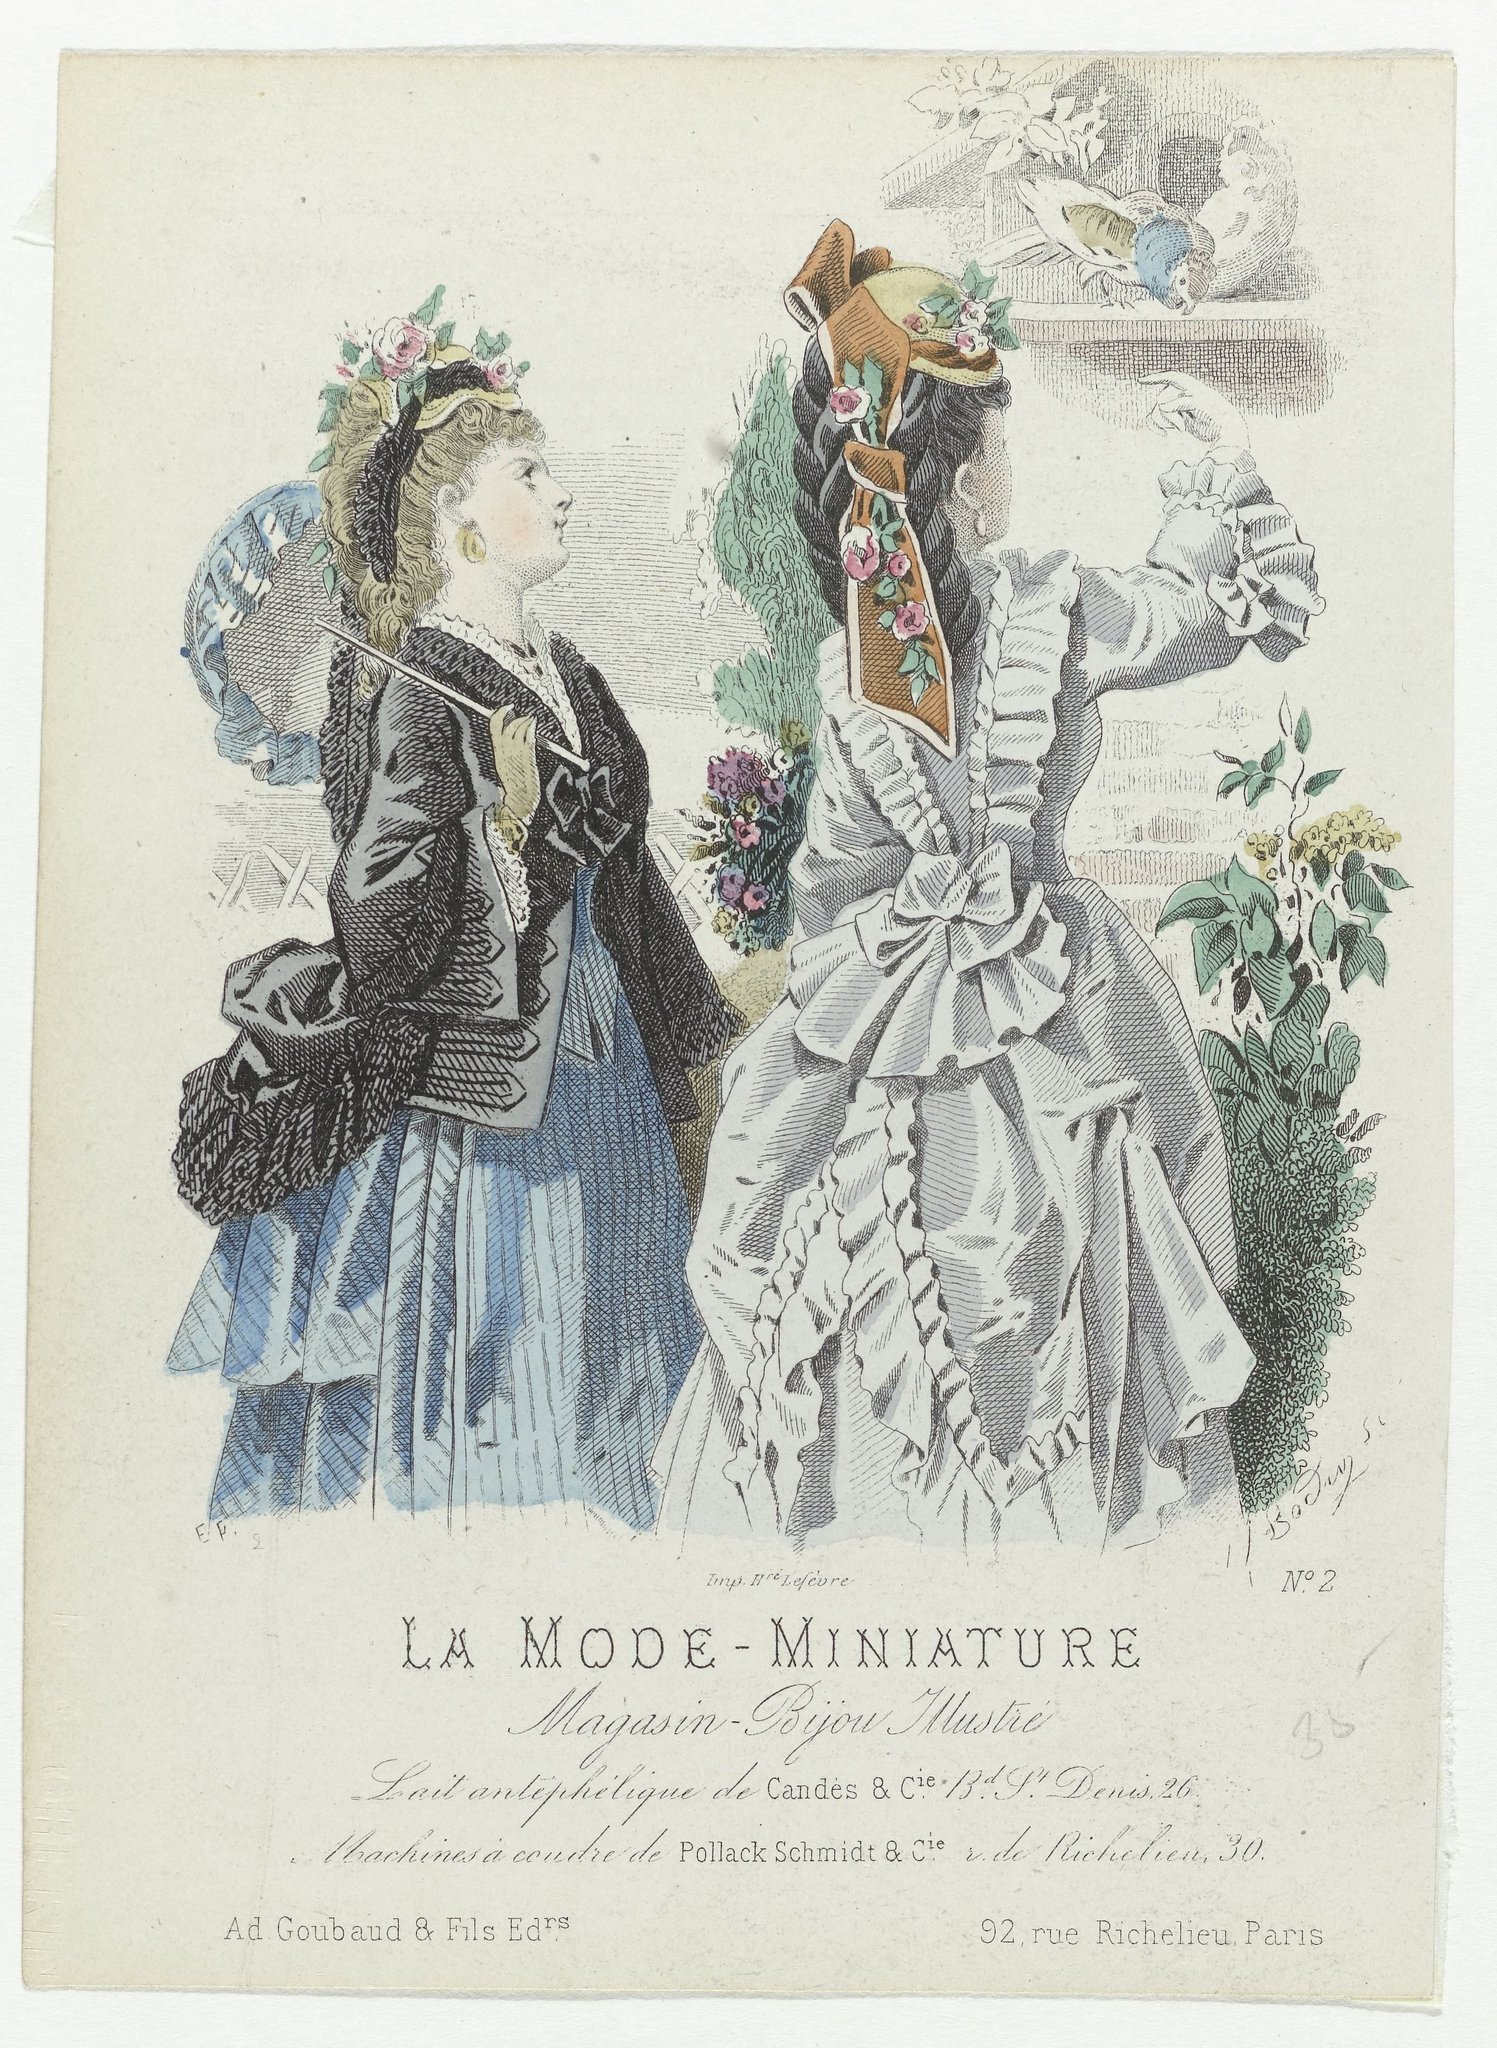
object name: fashion print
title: La Mode-Miniature, 1872, No. 2 : Lait antephéliqu (...)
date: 1872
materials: paper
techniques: engraving, hand coloring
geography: paris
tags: cut flowers; nosegay, bunch of flowers, coat (+ women's clothes), fashion plates, head-gear: hat (+ women's clothes), dove-cote, parasol, sunshade (+ women's clothes)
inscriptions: title: ‘La Mode-Miniature / Magasin - Bijou Illustré’, caption: ‘Lait antéphélique de Candes & Cie B.d S.t Denis 26. Machines à coudre de Pollack Schmidt & Cie r. de Richelieu, 30.’, address: ‘Ad Goubaud & Fils Ed.rs / 92, rue Richelieu Paris’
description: Twee vrouwen, van wie één op de rug gezien, staan bij een duiventil. Onder de voorstelling enkele regels reclametekst voor verschillende producten. Prent uit het modetijdschrift La Mode Miniature (1872-1873). De prent is een verkleinde kopie van No 1044B uit het modetijdschrift Le Moniteur des Dames et des Demoiselles.